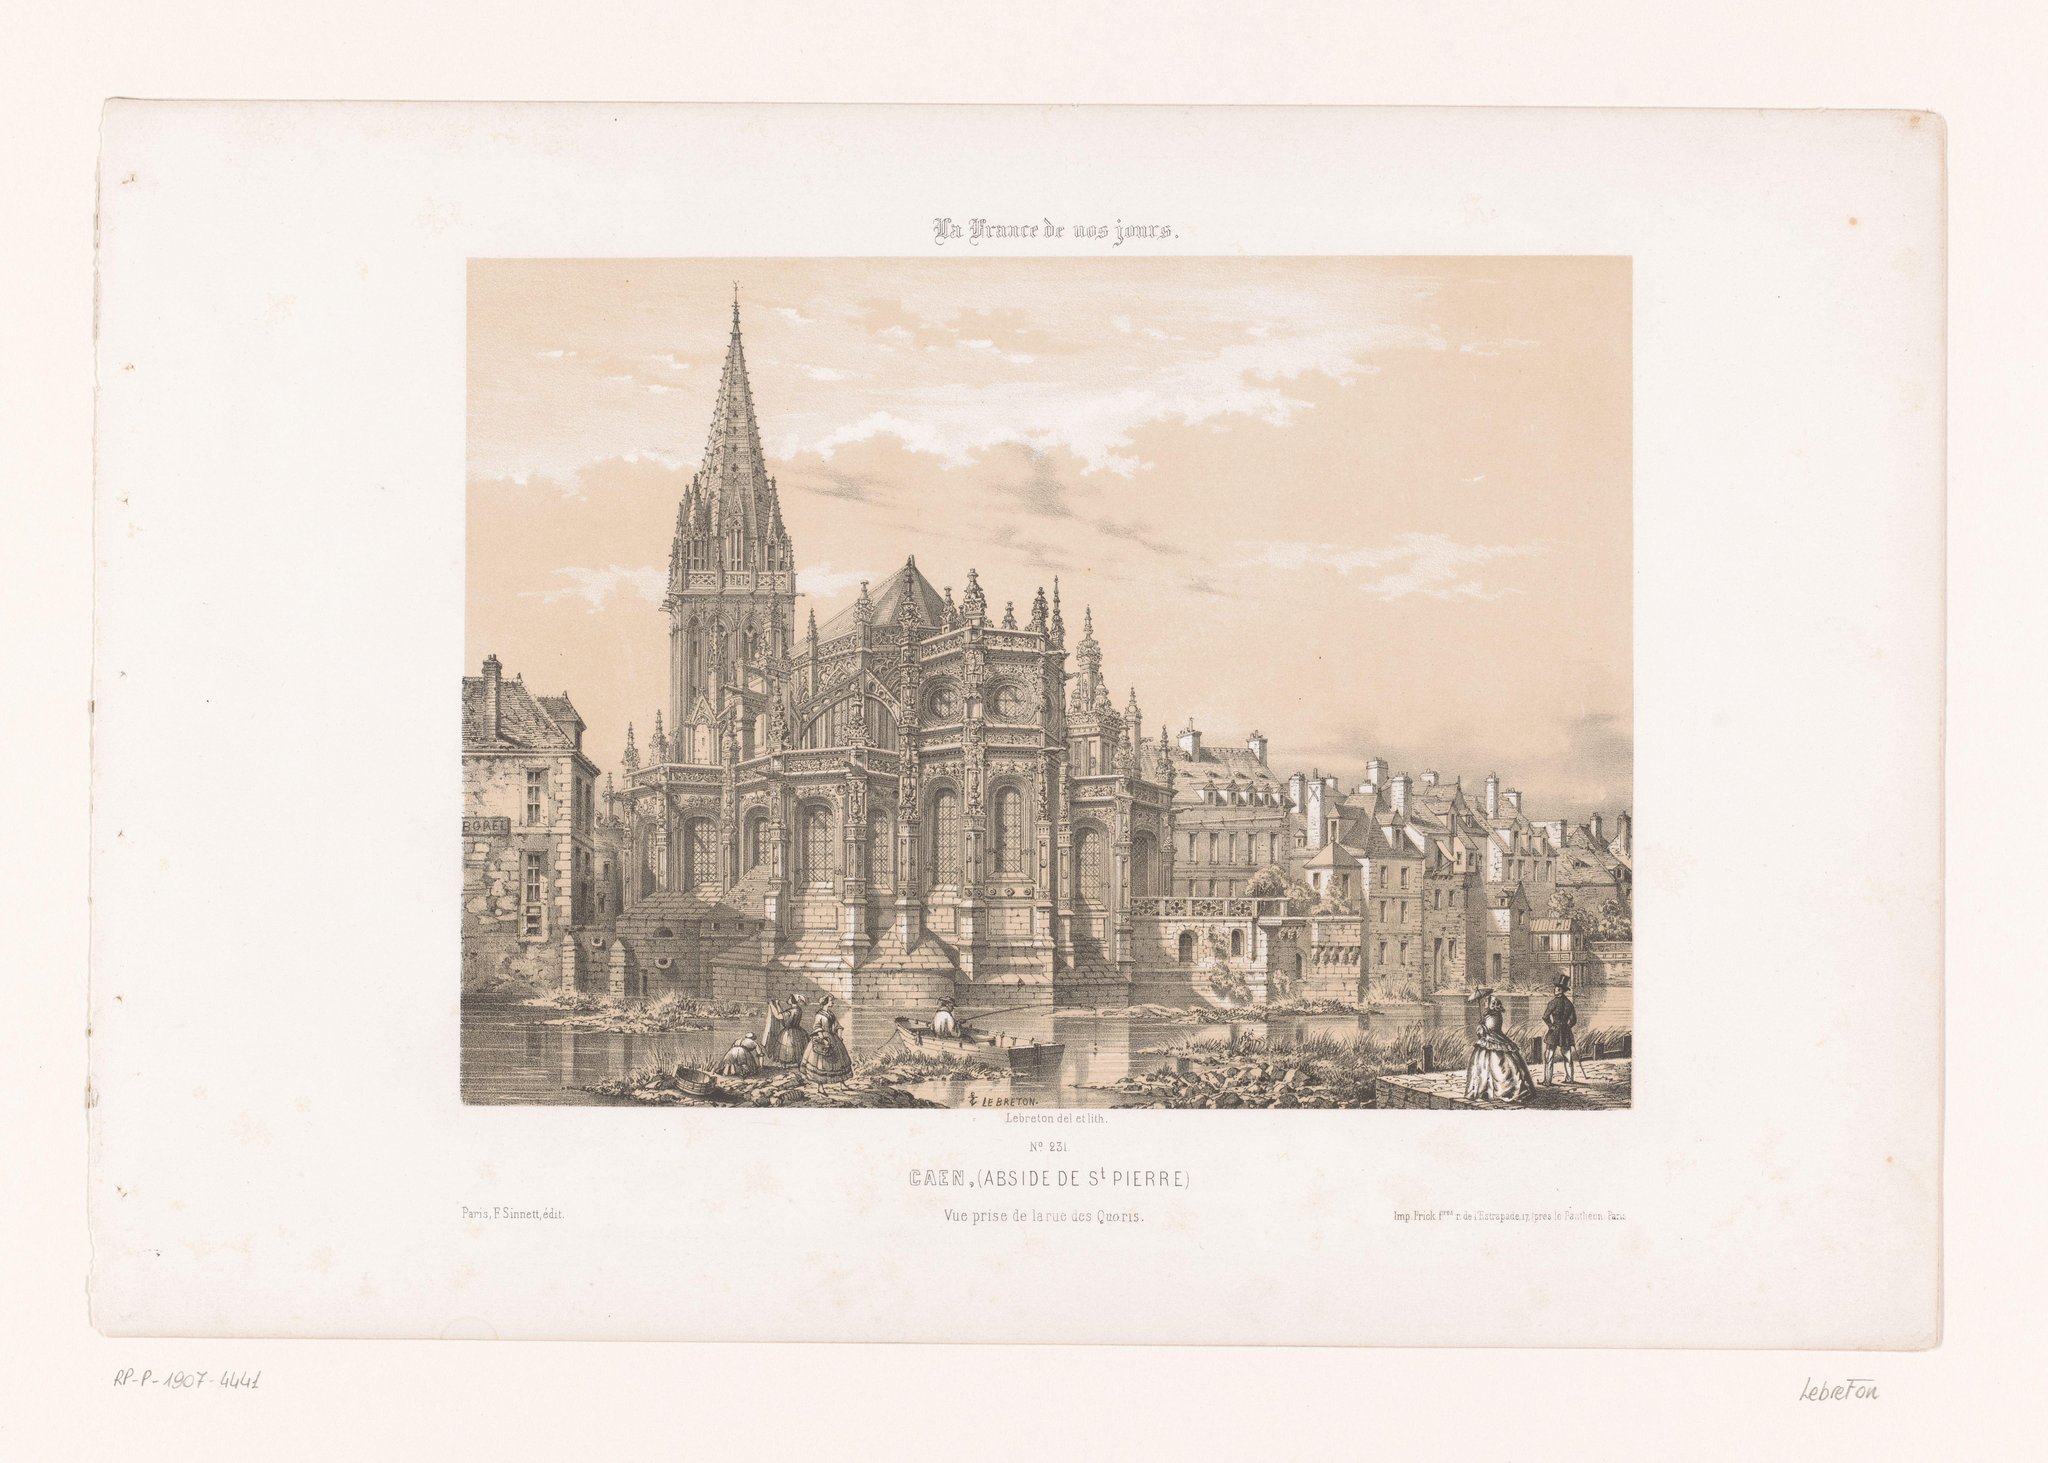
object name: print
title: Hedendaags Frankrijk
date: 1855-1859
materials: paper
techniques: tone lithography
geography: paris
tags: church (exterior), canals, waters (in city) (+ city(-scape) with figures, staffage)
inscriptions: collector's mark: Lugt 2228a